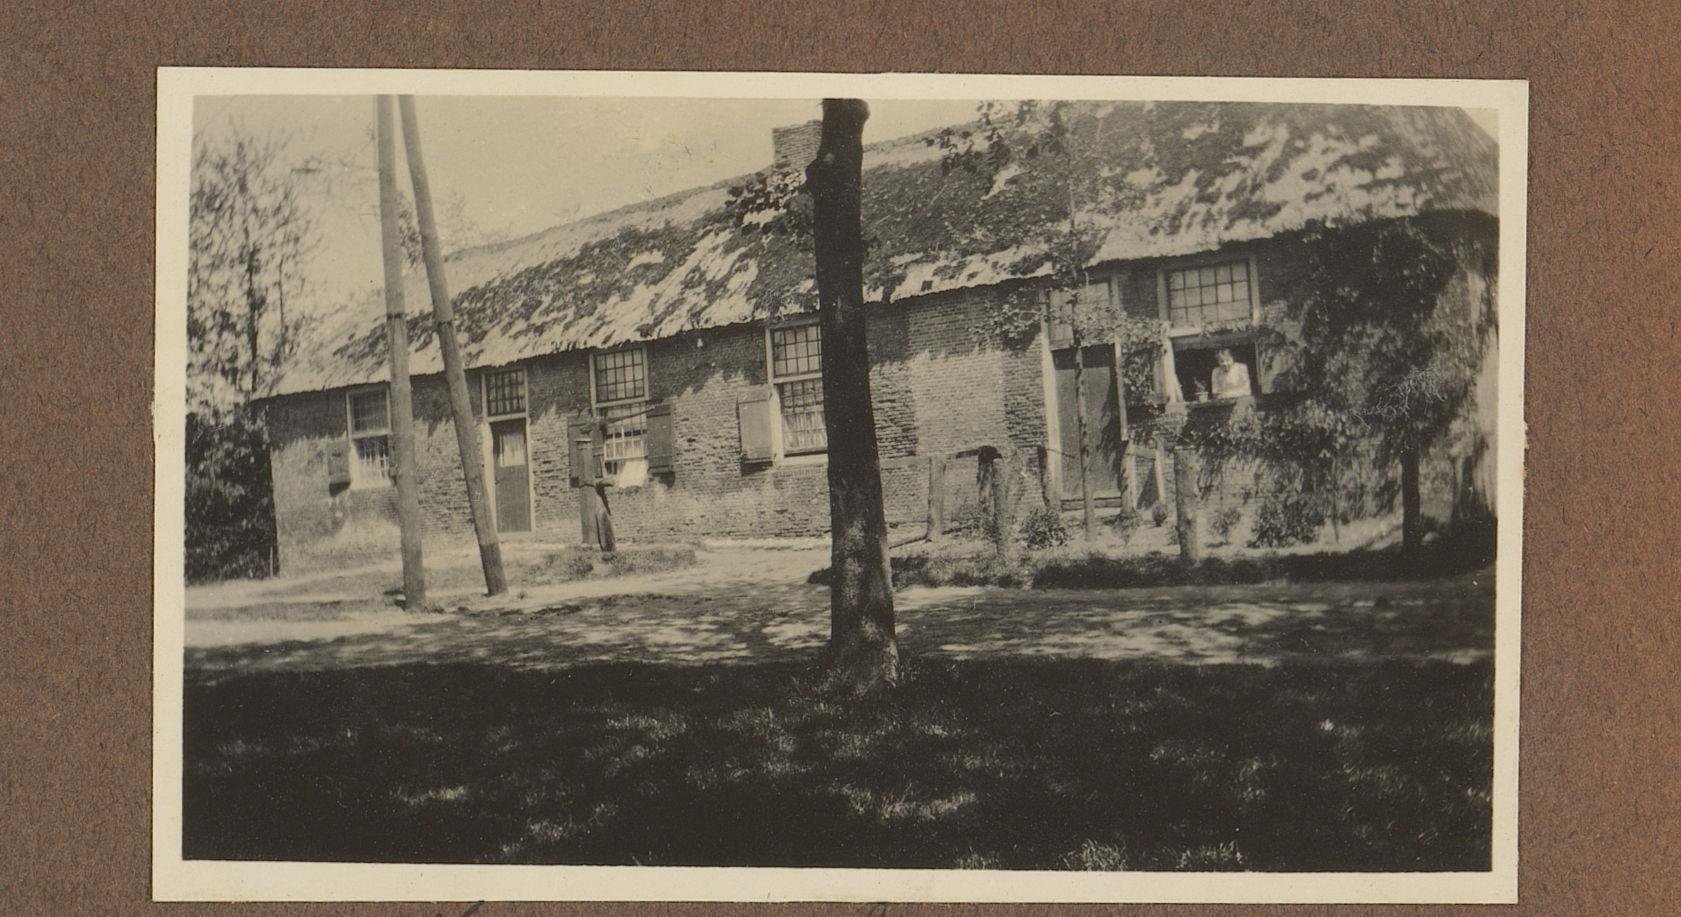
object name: photograph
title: Zevenend Laren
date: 1900-1925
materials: photographic support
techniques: photography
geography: amsterdam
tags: laren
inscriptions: inscription: ‘Zevenend. Laren.’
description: Foto op bruin albumblad 25 van familiealbum van Alphons Diepenbrock.